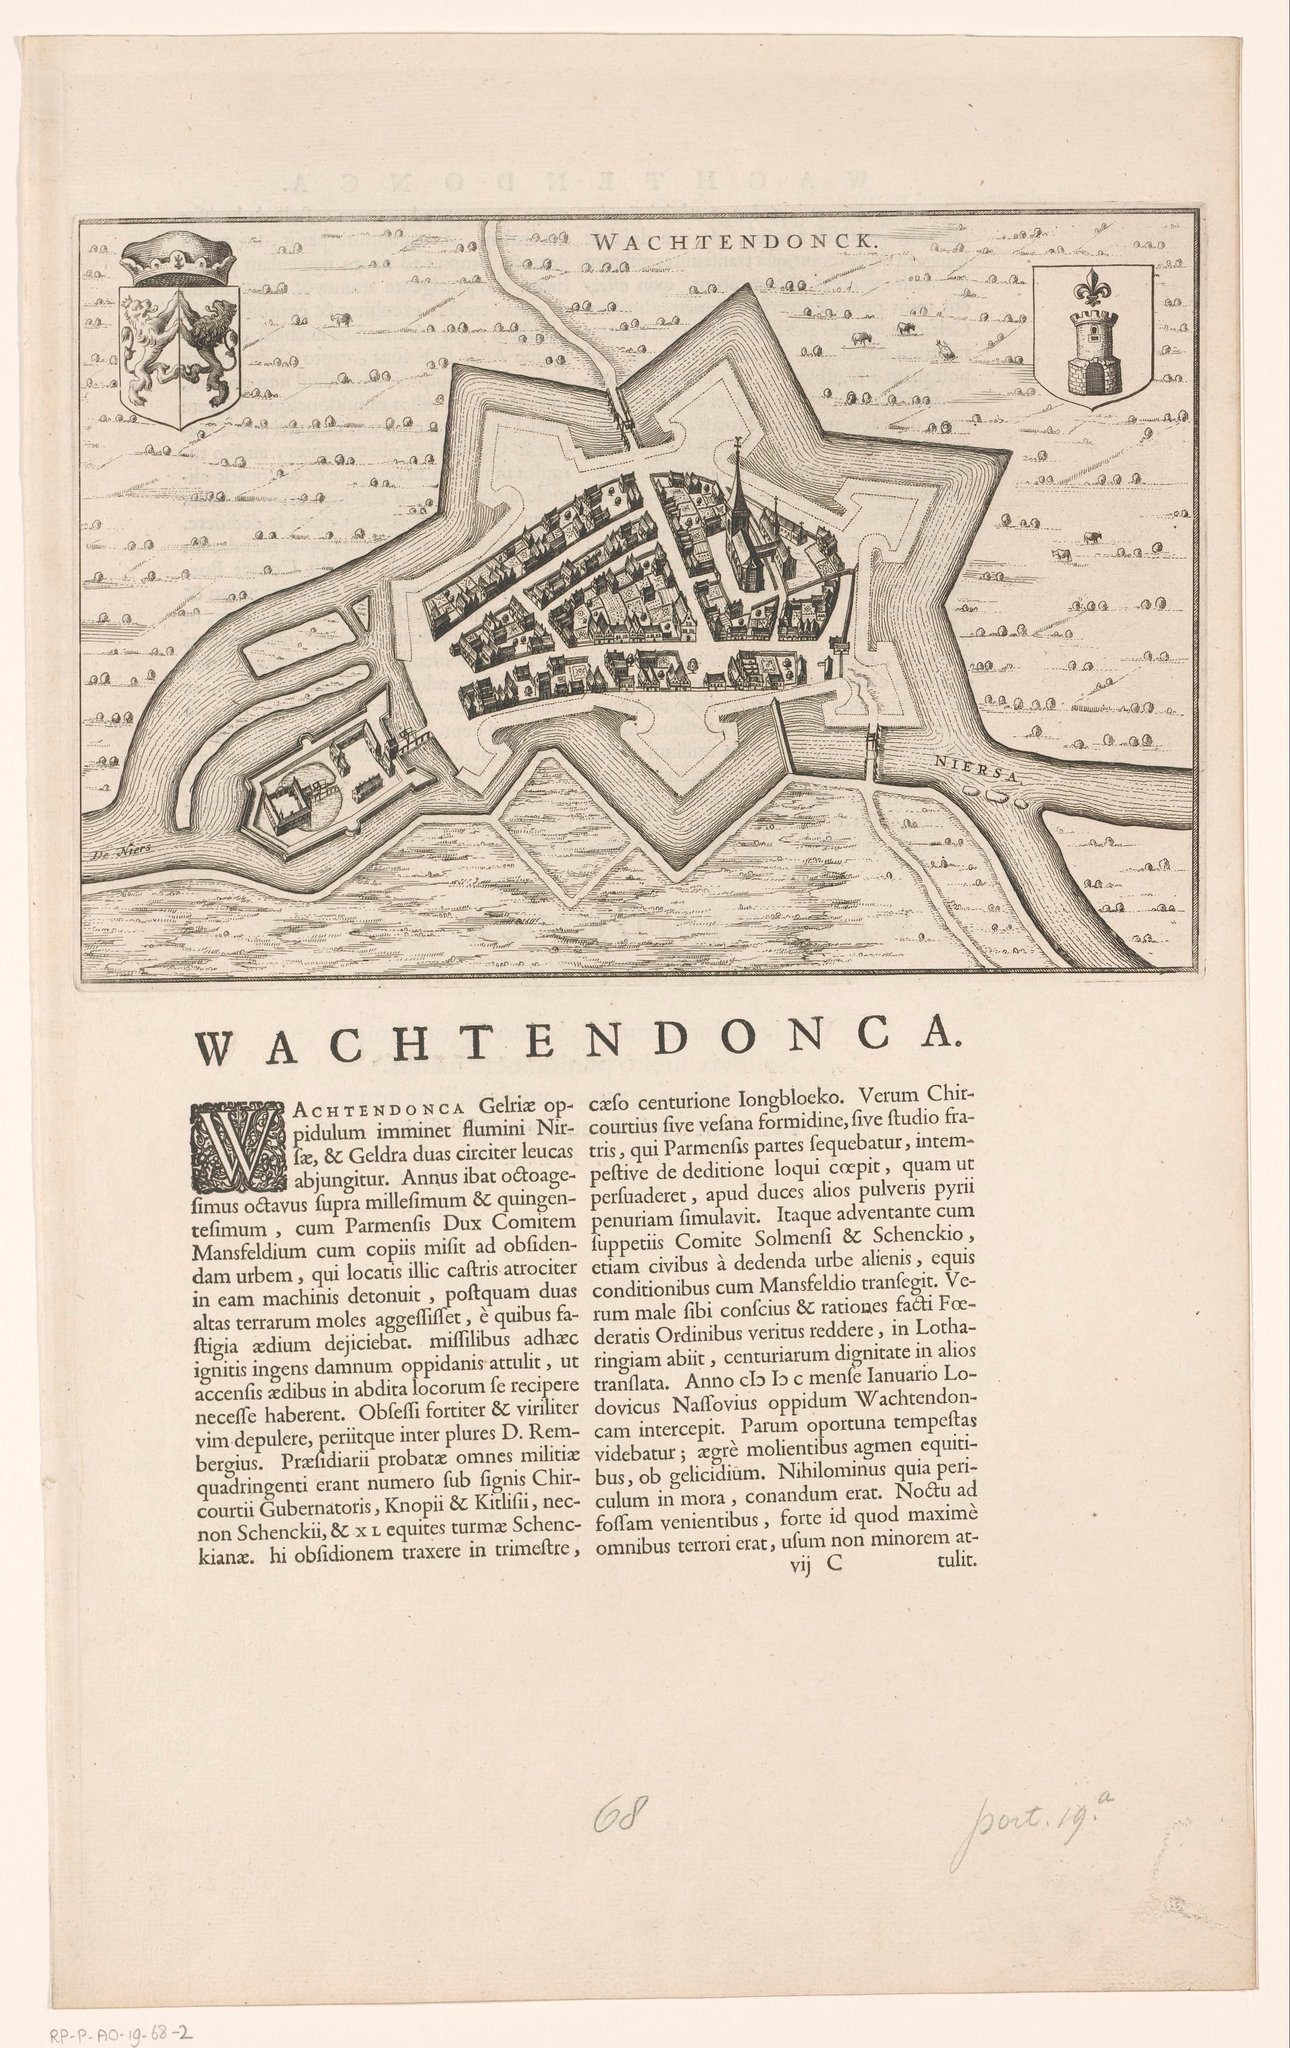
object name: print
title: Wachtendonck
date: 1652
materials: paper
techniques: engraving, etching, letterpress printing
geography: amsterdam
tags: coat of arms (as symbol of the state, etc.) (+ city; municipal), maps of cities, coat of arms (as symbol of the state, etc.) (+ province; provincial)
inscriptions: collector's mark: Lugt 2228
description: Plattegrond van Wachtendonk. Boven de titel. Linksboven het wapen van het hertogdom Gelre, rechtsboven het wapen van Wachtendonk. Hieronder een beschrijving van Wachtendonk in het Latijn. Met Latijnse tekst op verso.